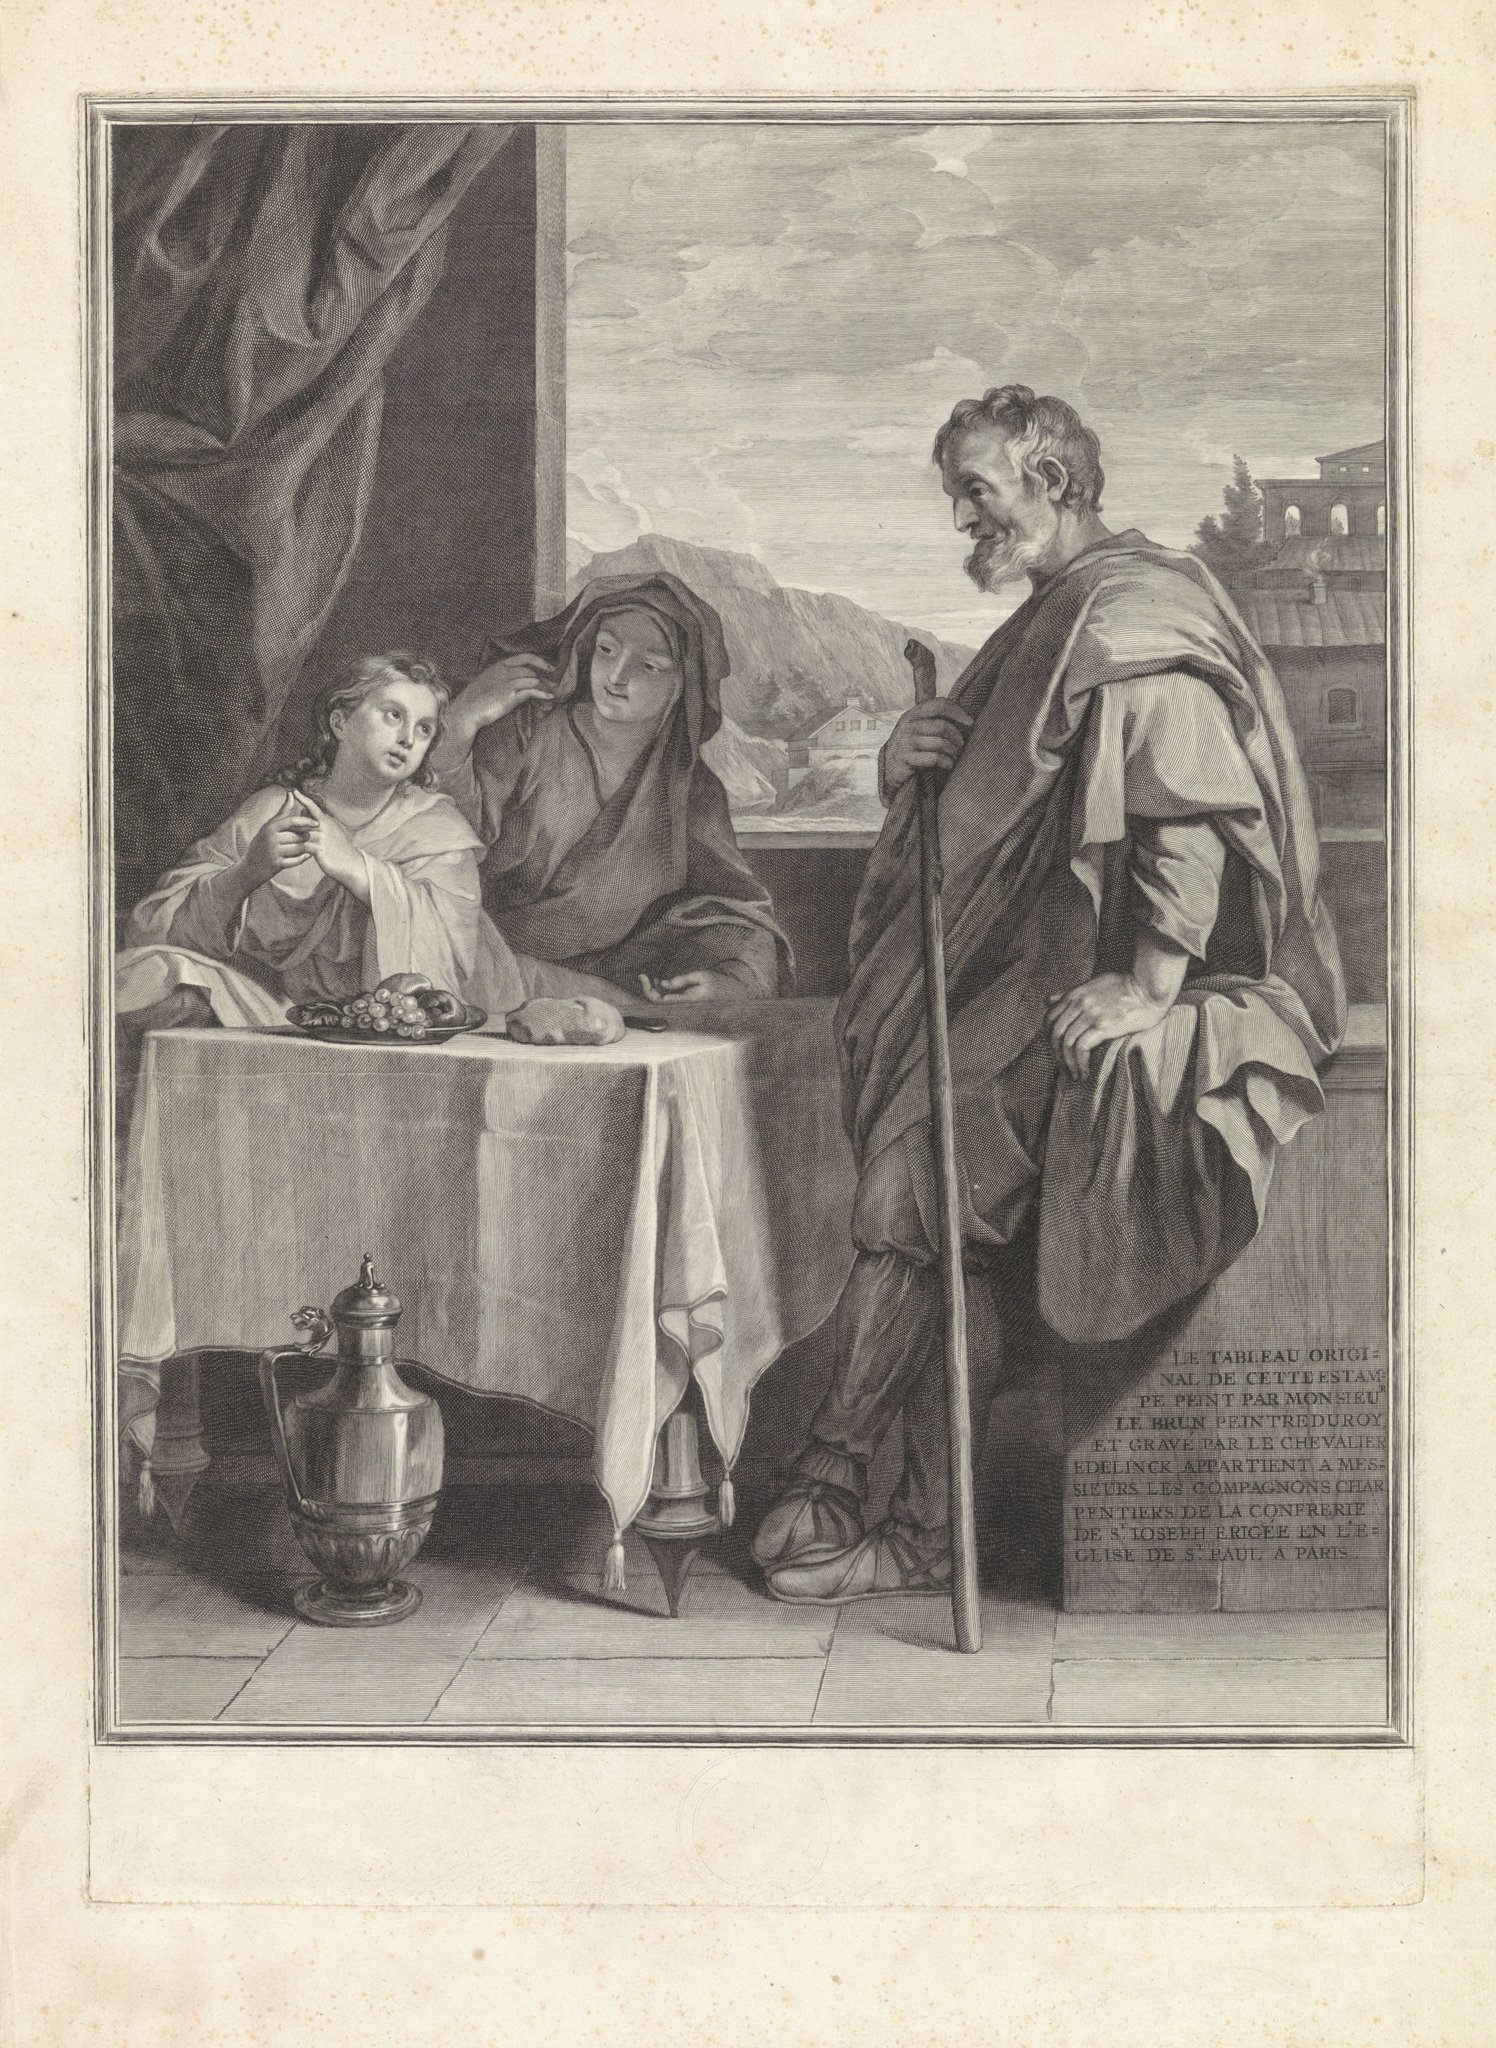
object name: print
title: Heilige familie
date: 1704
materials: paper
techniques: engraving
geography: paris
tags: holy family, and derived representations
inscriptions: collector's mark: Lugt 240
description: Christus zit met Maria aan tafel en kijkt naar Jozef, die tegen een sokkel leunt. Door het venster een gezicht op een berglandschap. Op de sokkel een Franse tekst van tien regels.